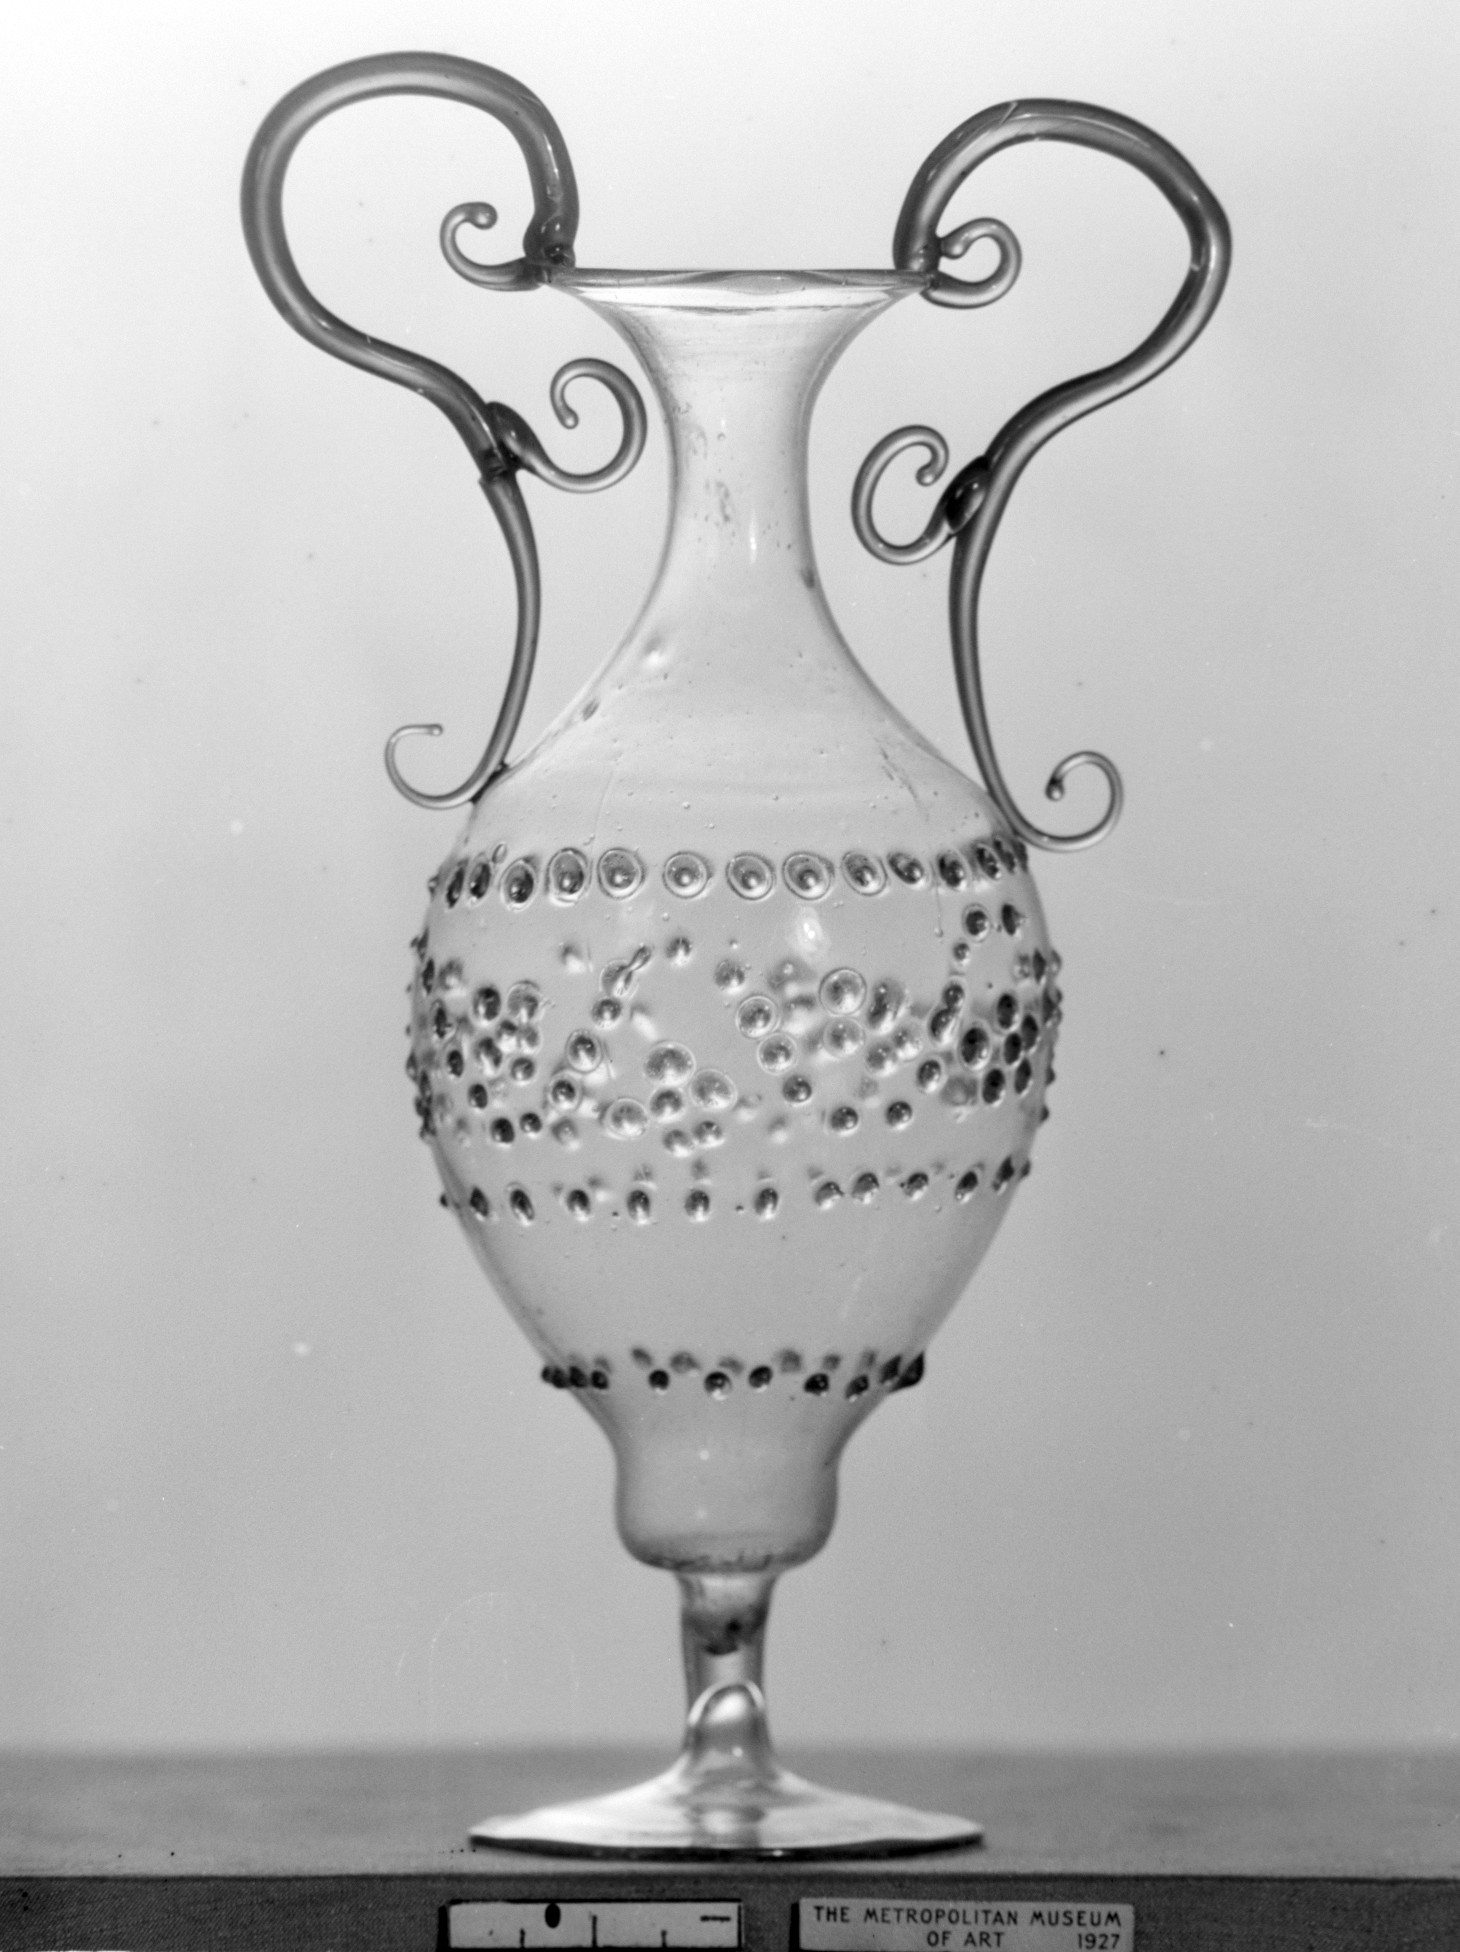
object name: vase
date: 1801-1900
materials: glass